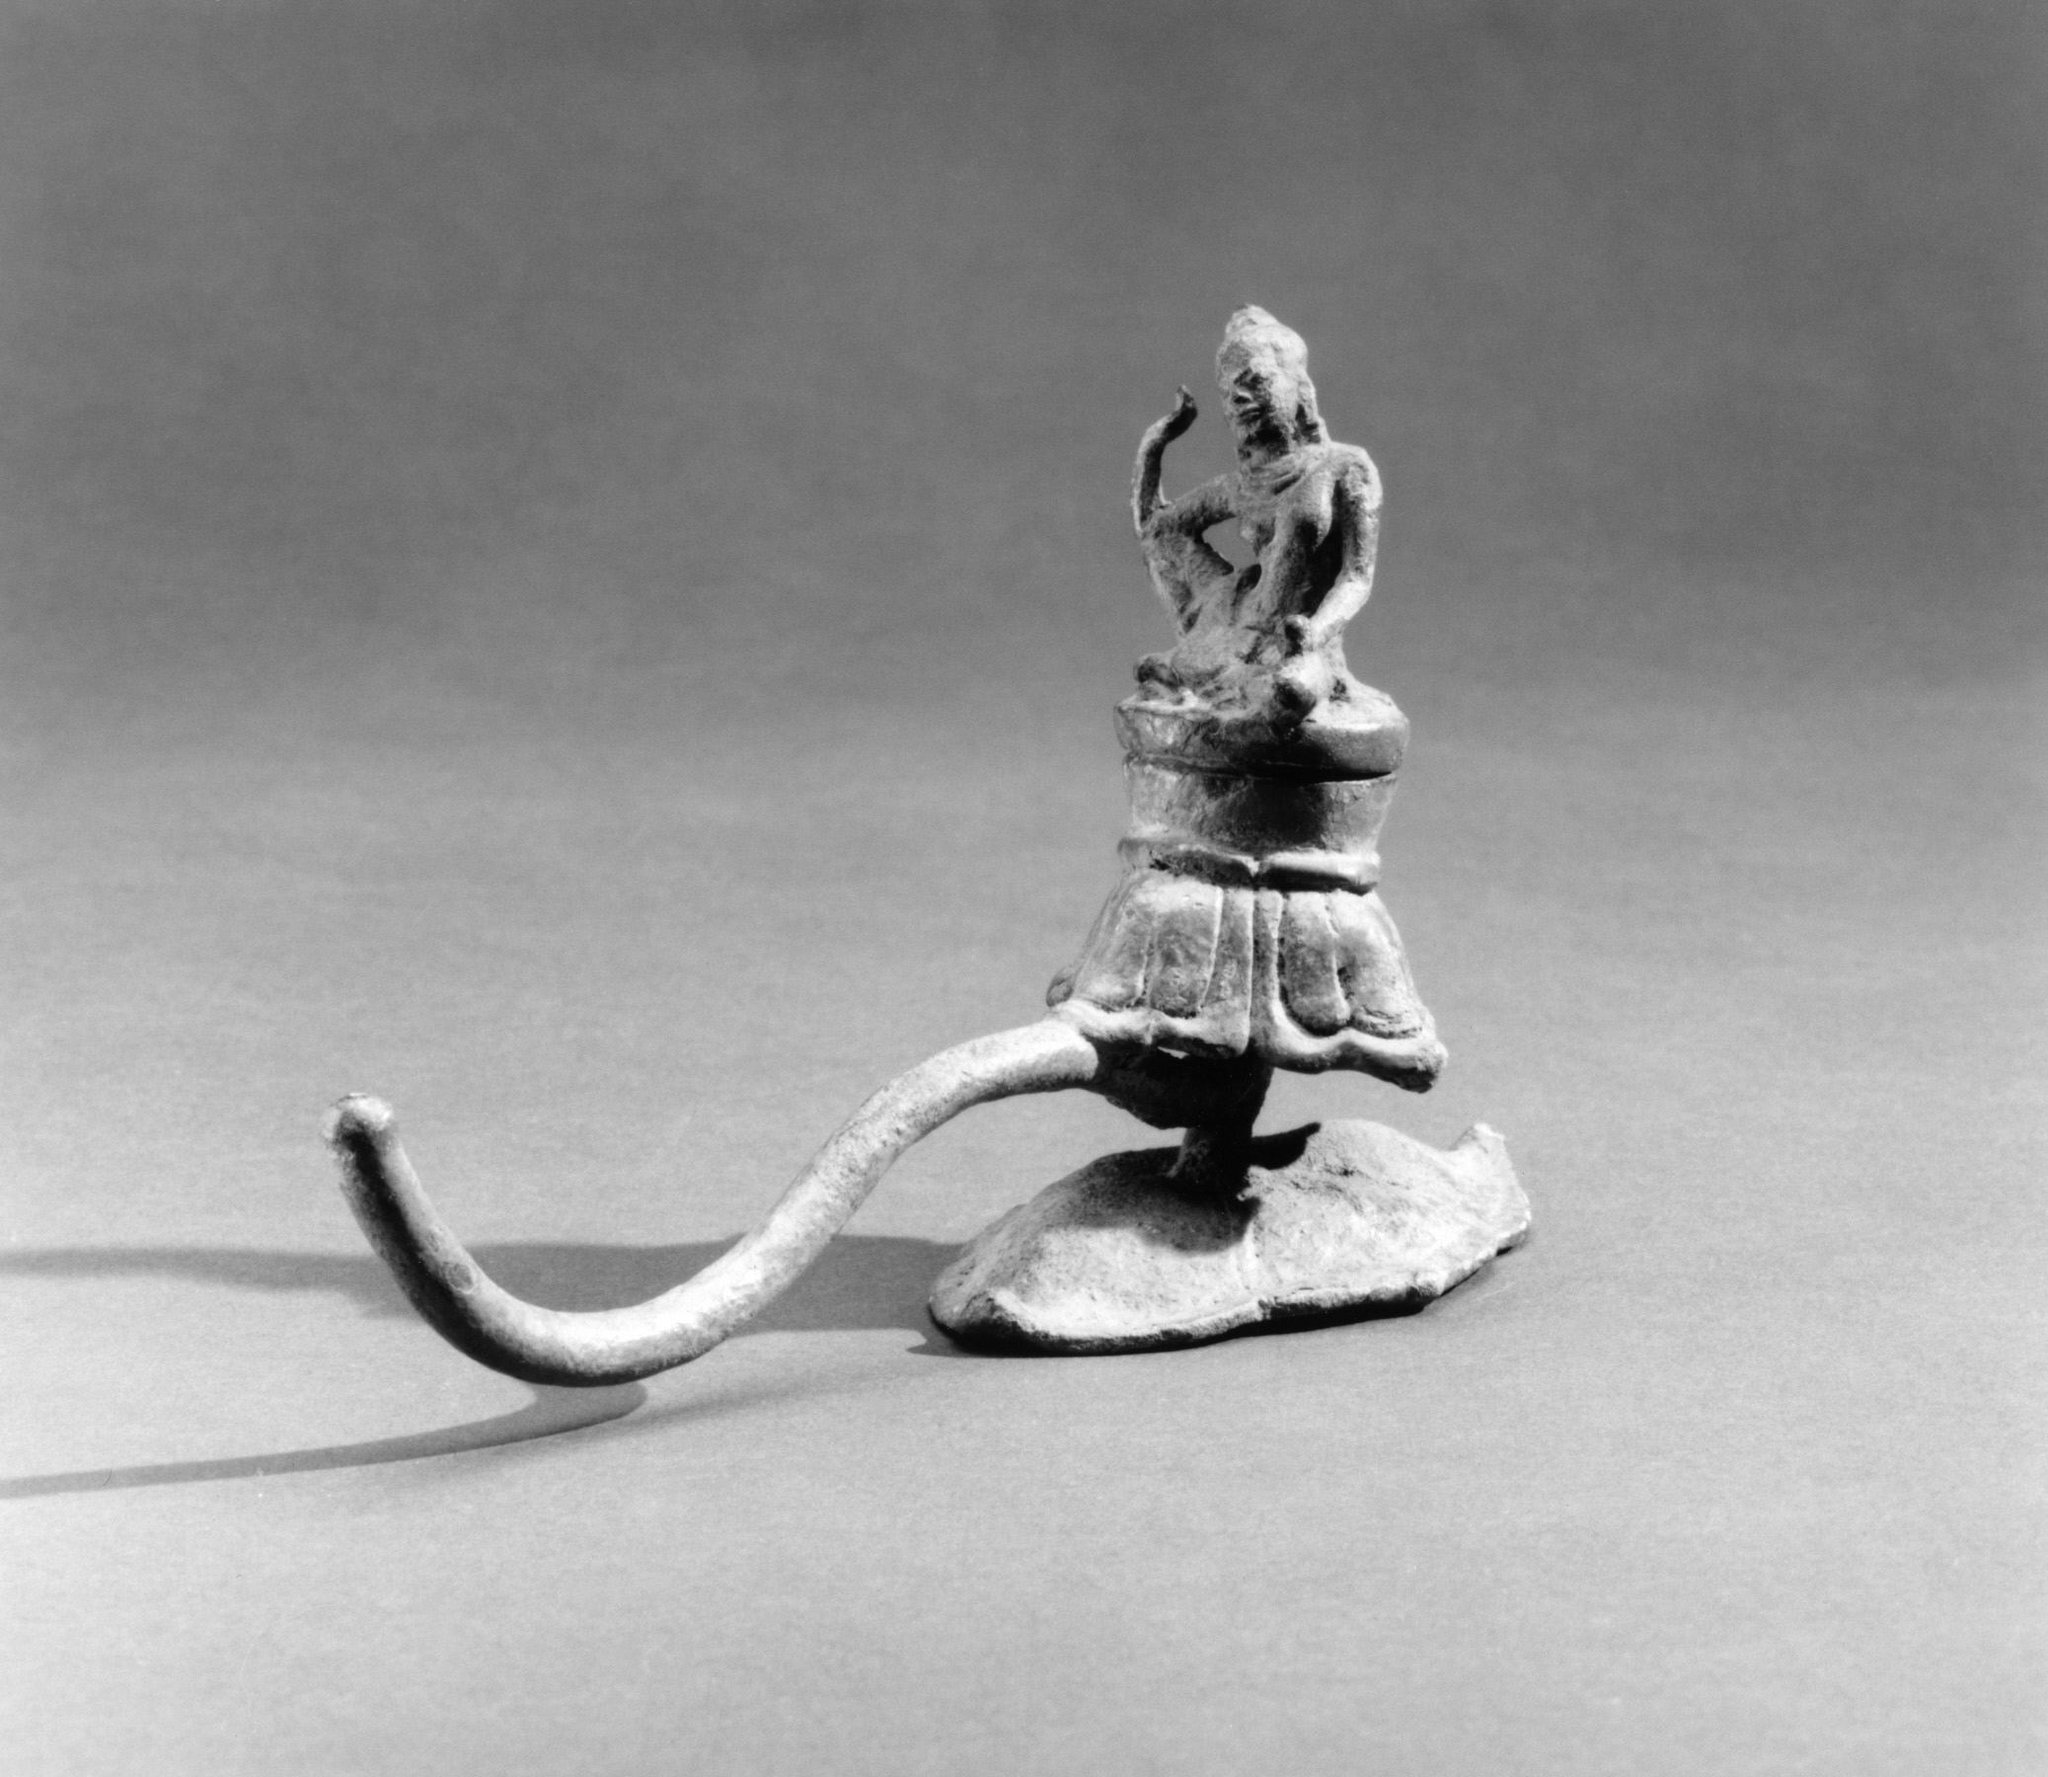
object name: container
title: Container in the Form of a Lotus Surmounted by a Female Figure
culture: thai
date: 1101-1150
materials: bronze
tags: women,lotuses